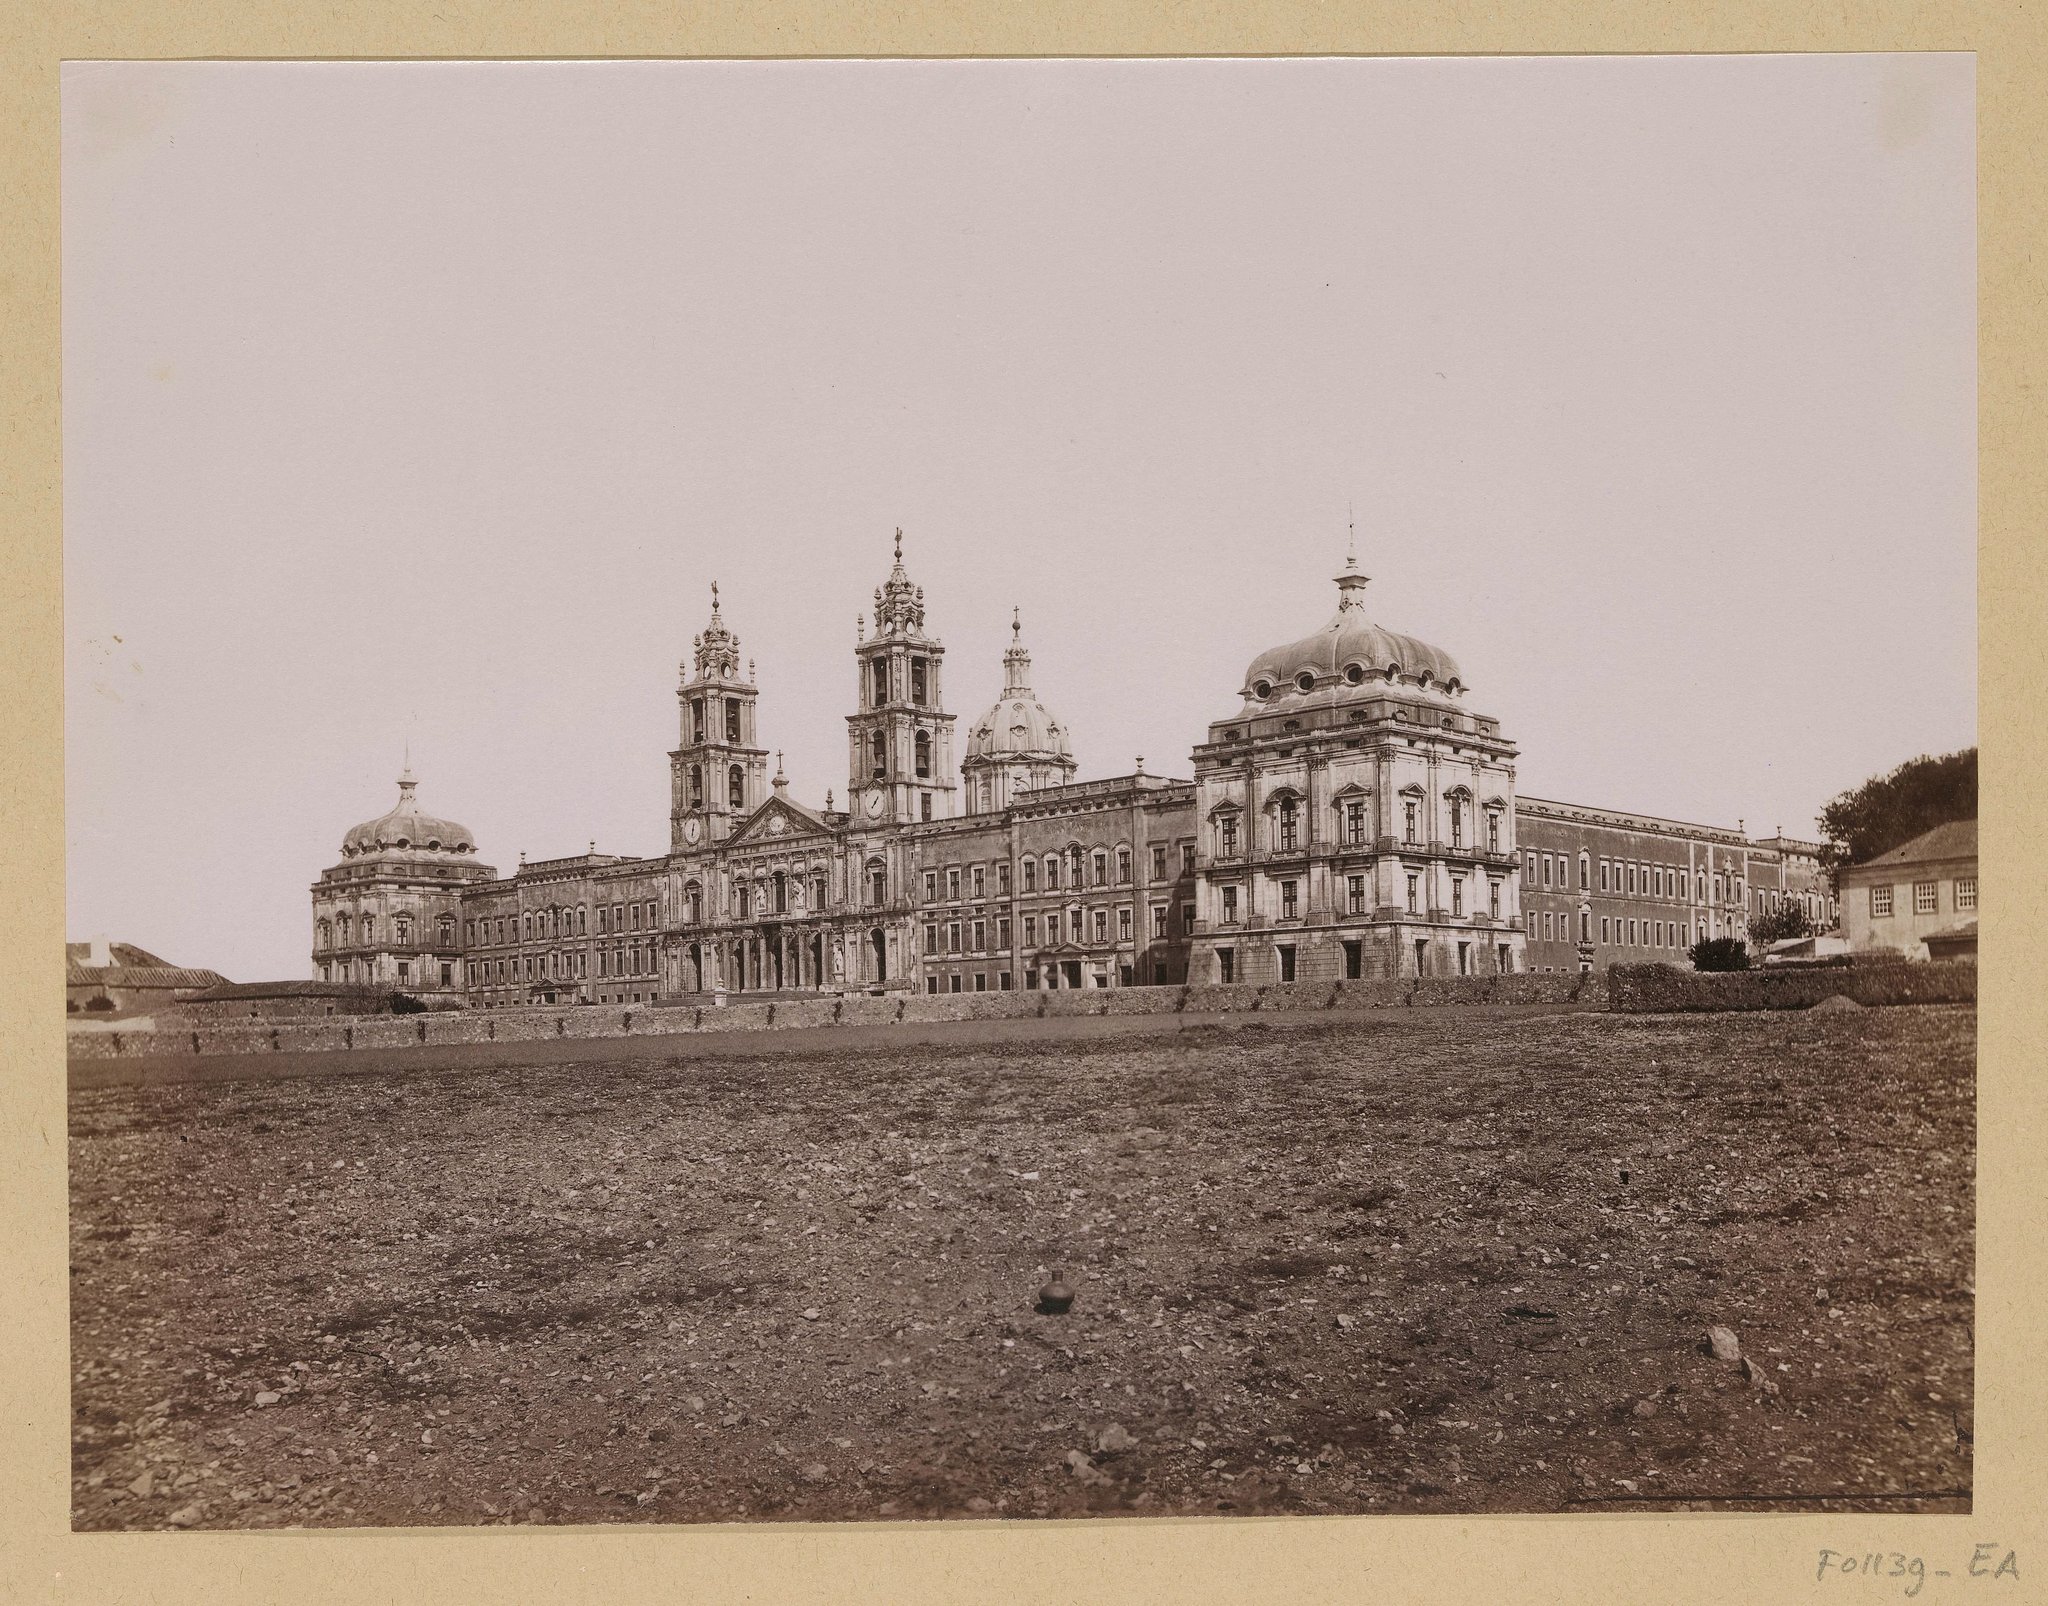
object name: photograph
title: Gezicht op het Paleis van Mafra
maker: Anonymous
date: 1851-1890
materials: paper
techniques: albumen print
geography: mafra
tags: palace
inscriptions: inscription: ‘Mafra’